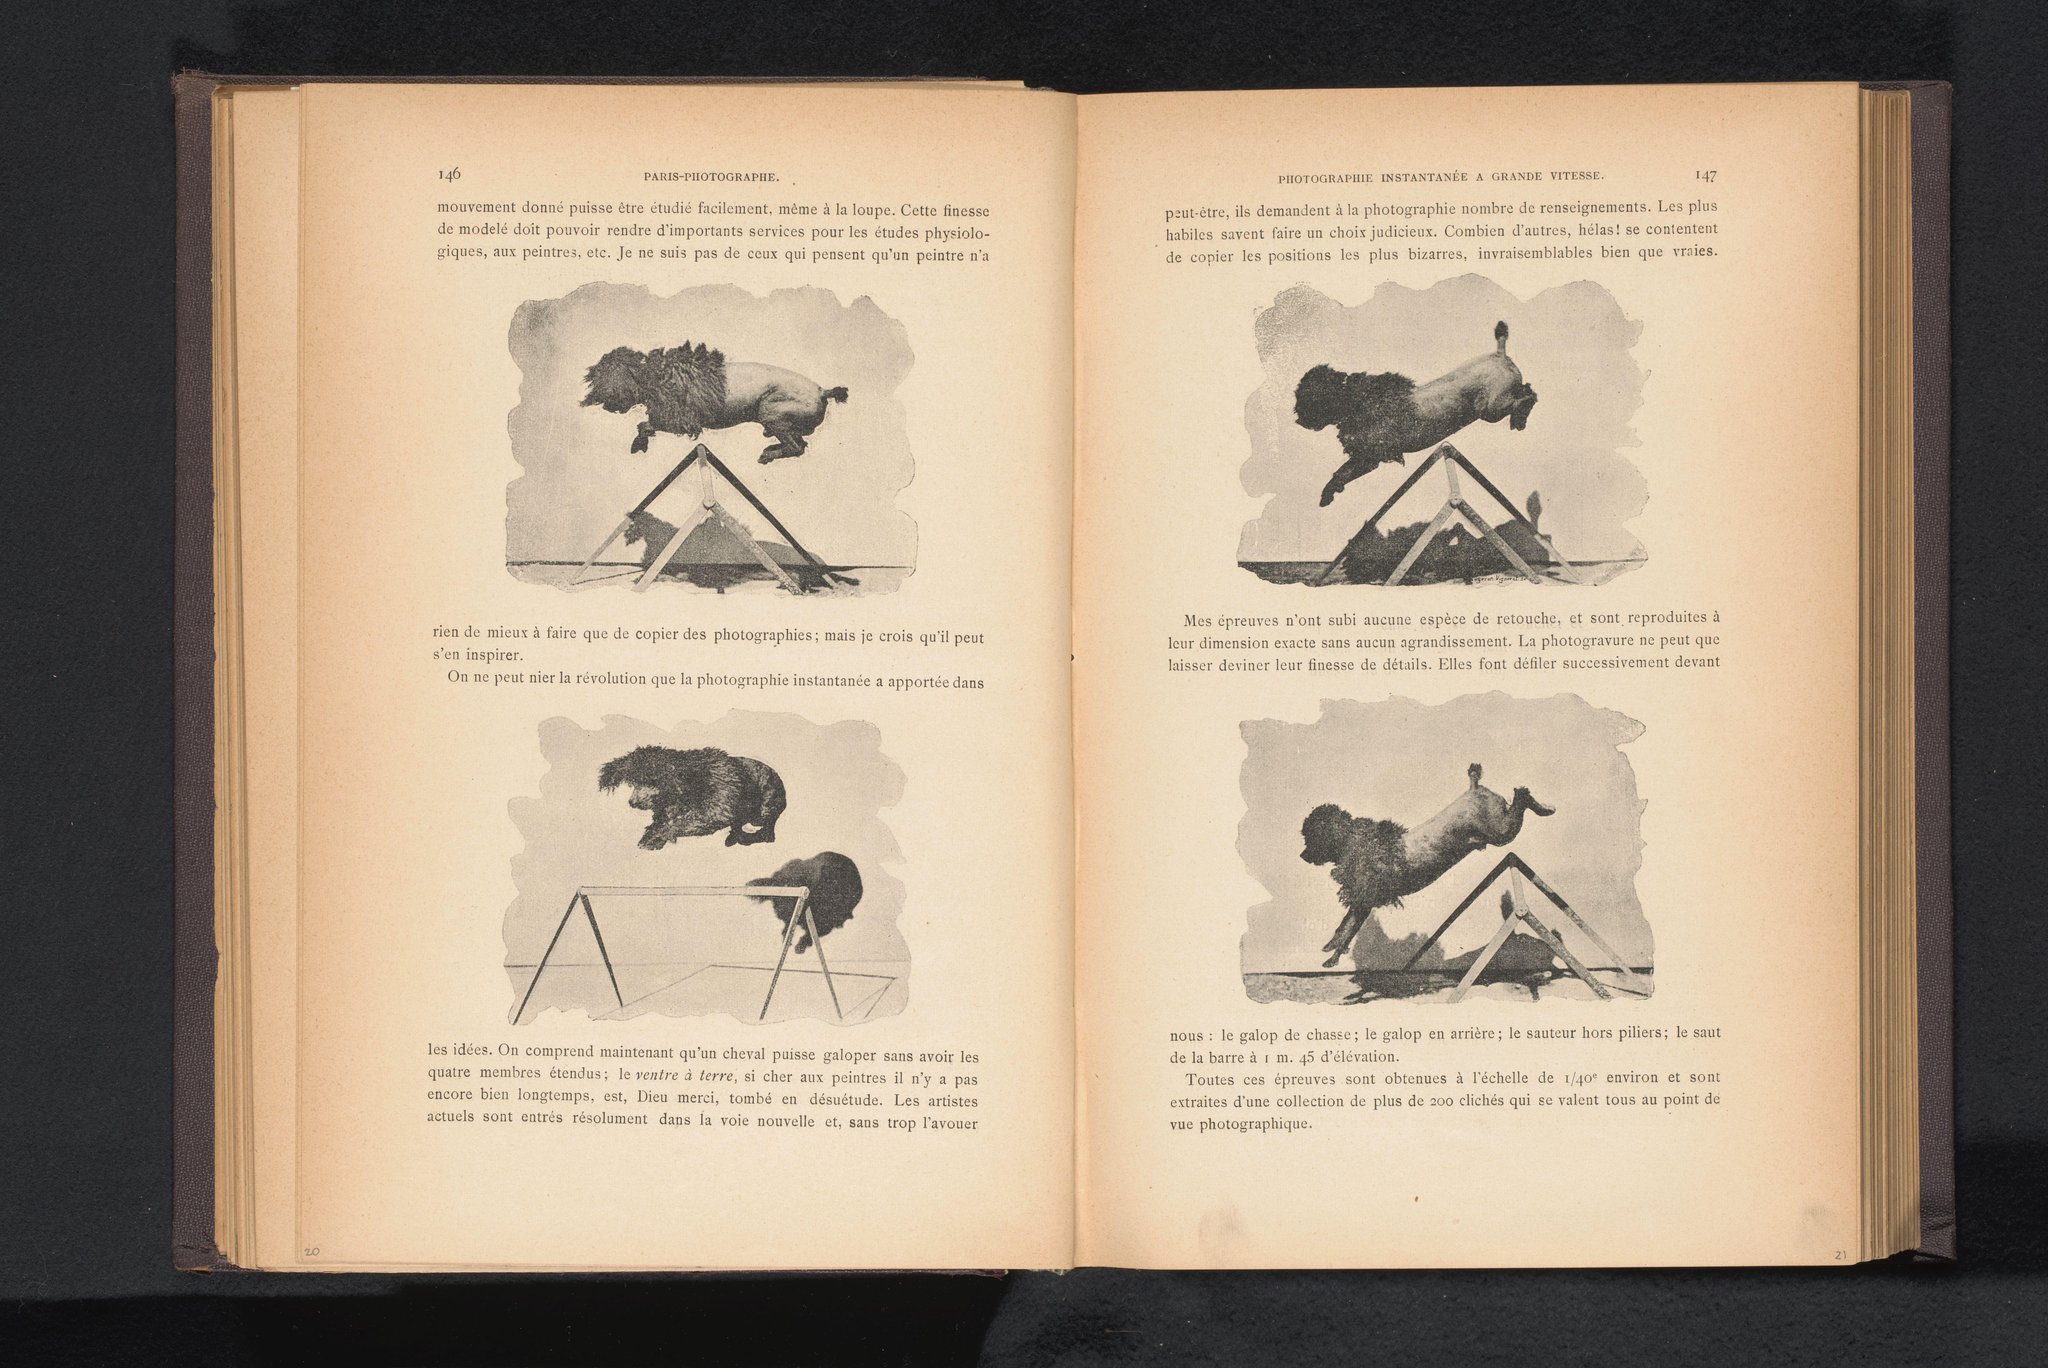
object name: photomechanical print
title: Tweemaal een springende poedel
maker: Anonymous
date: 1883-1893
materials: paper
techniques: autotype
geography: france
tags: jumping down, dog